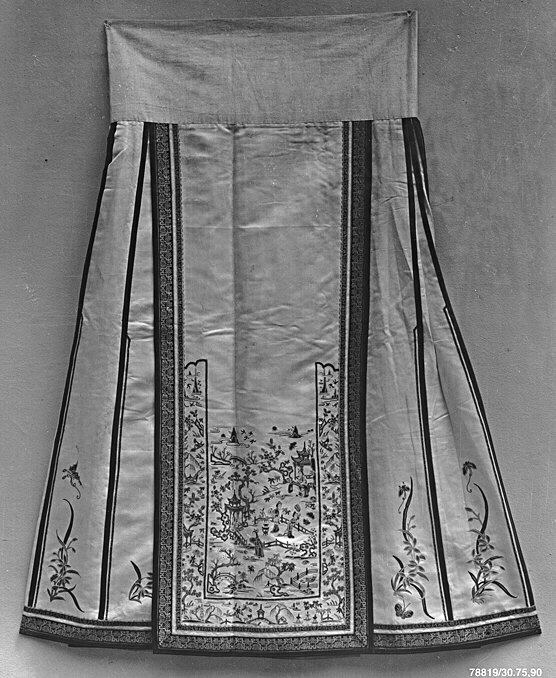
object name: skirt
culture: chinese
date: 1801-1900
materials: silk